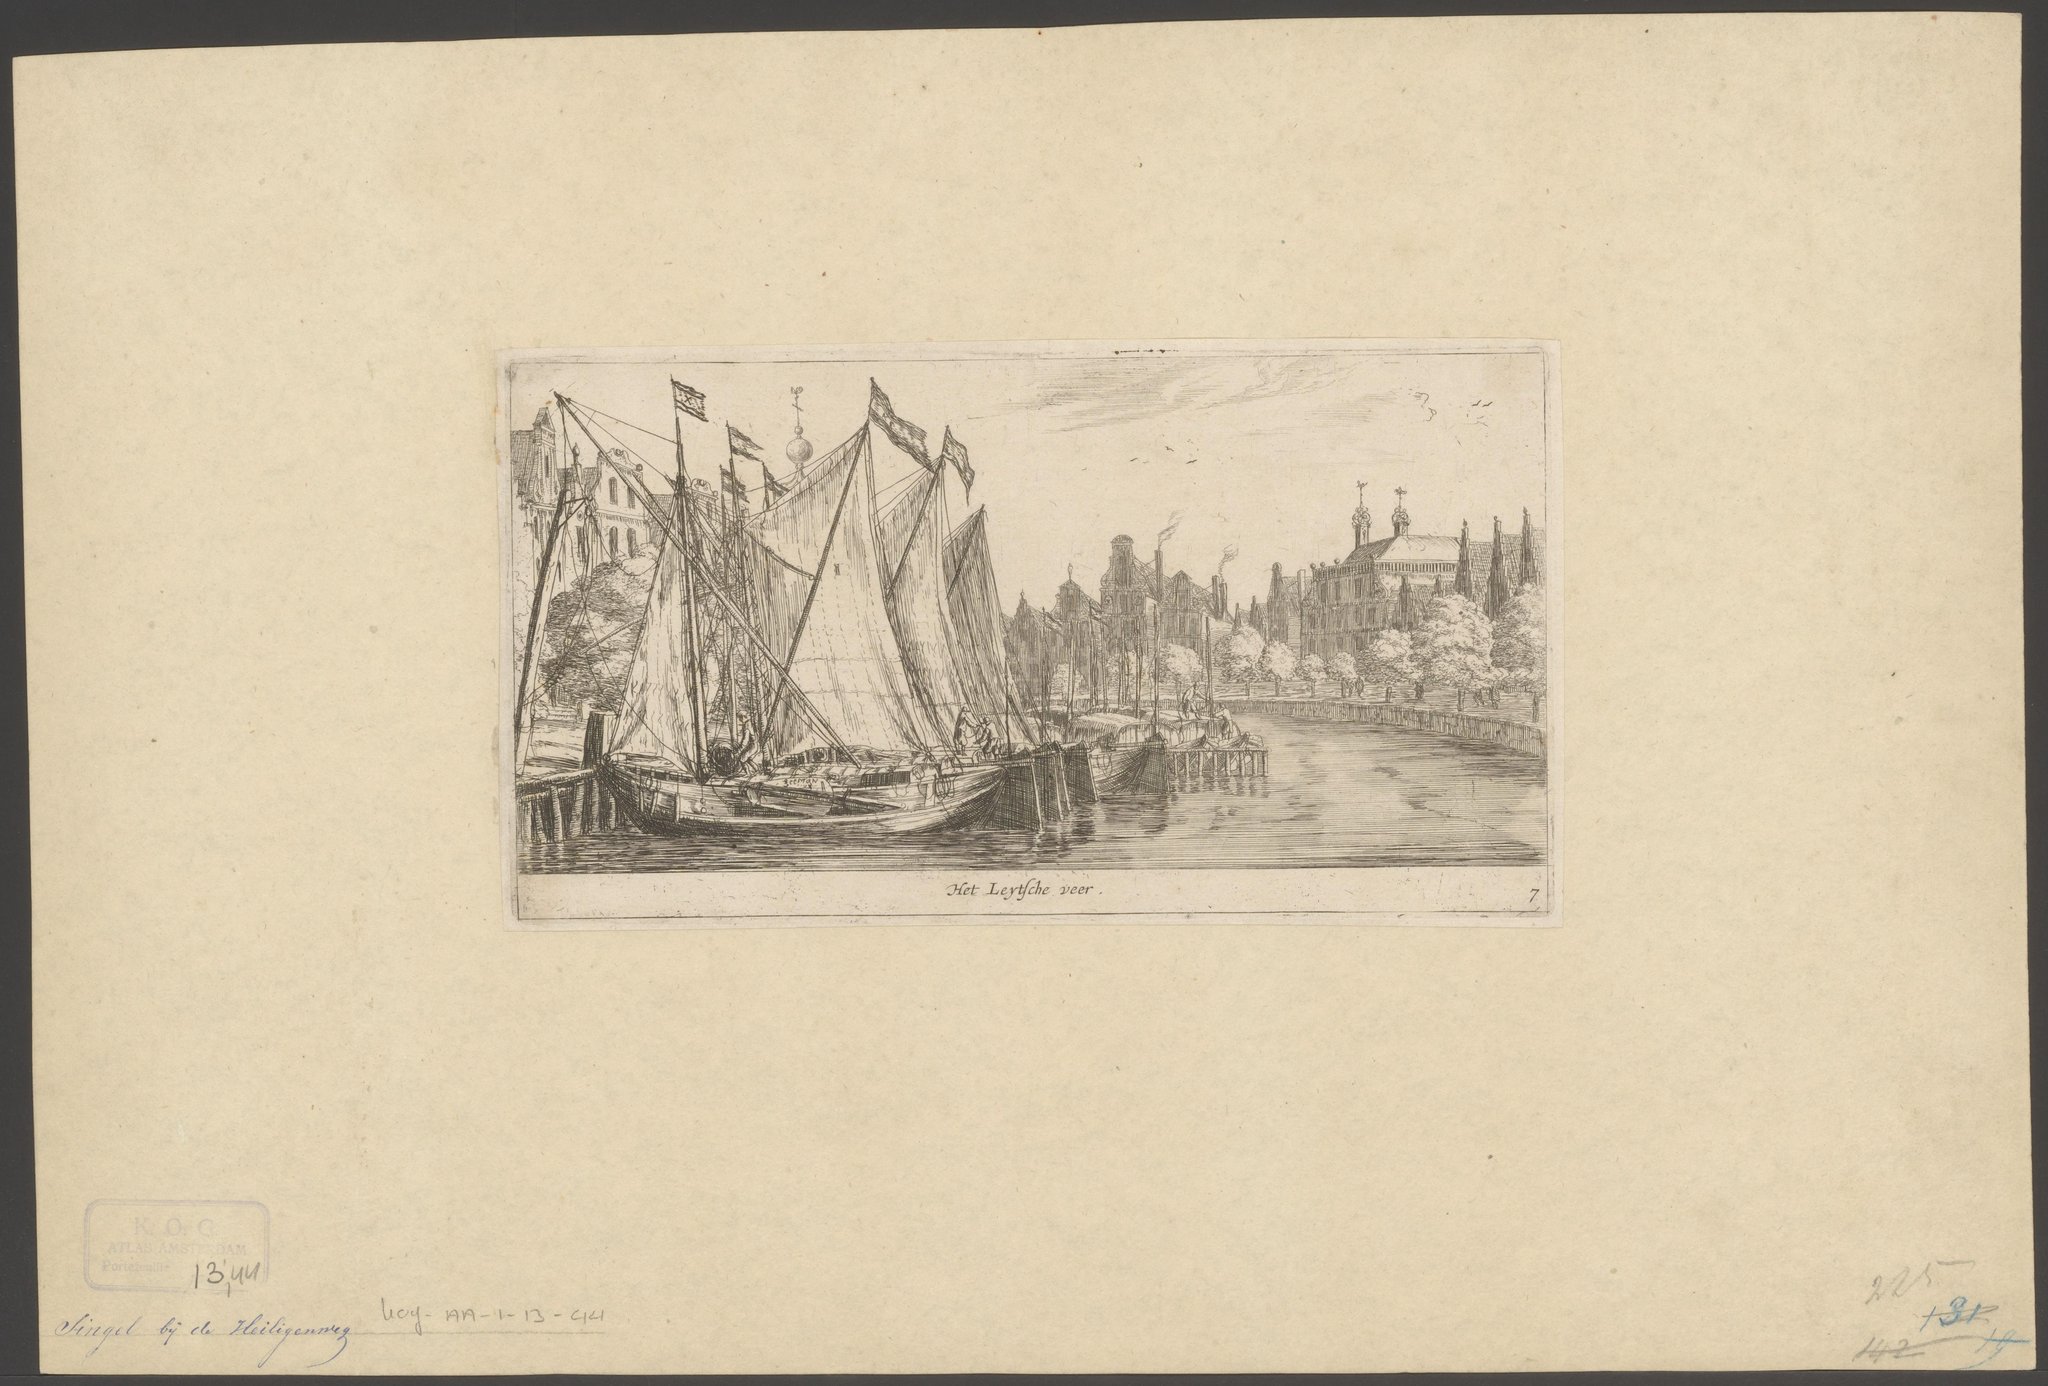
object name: print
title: Gezichten op Amsterdam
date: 1659-1662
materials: paper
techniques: etching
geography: amsterdam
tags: sailing-ship, sailing-boat, city-view in general; 'veduta', canal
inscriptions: collector's mark: ‘13,44’ Lugt 1641b, inscription: ‘Singel bij de Heiligenweg’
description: Onderwerpsrubriek binnen de Atlas Amsterdam: Oude Schans, Schoutensteeg, Singel (Korte), Singel.